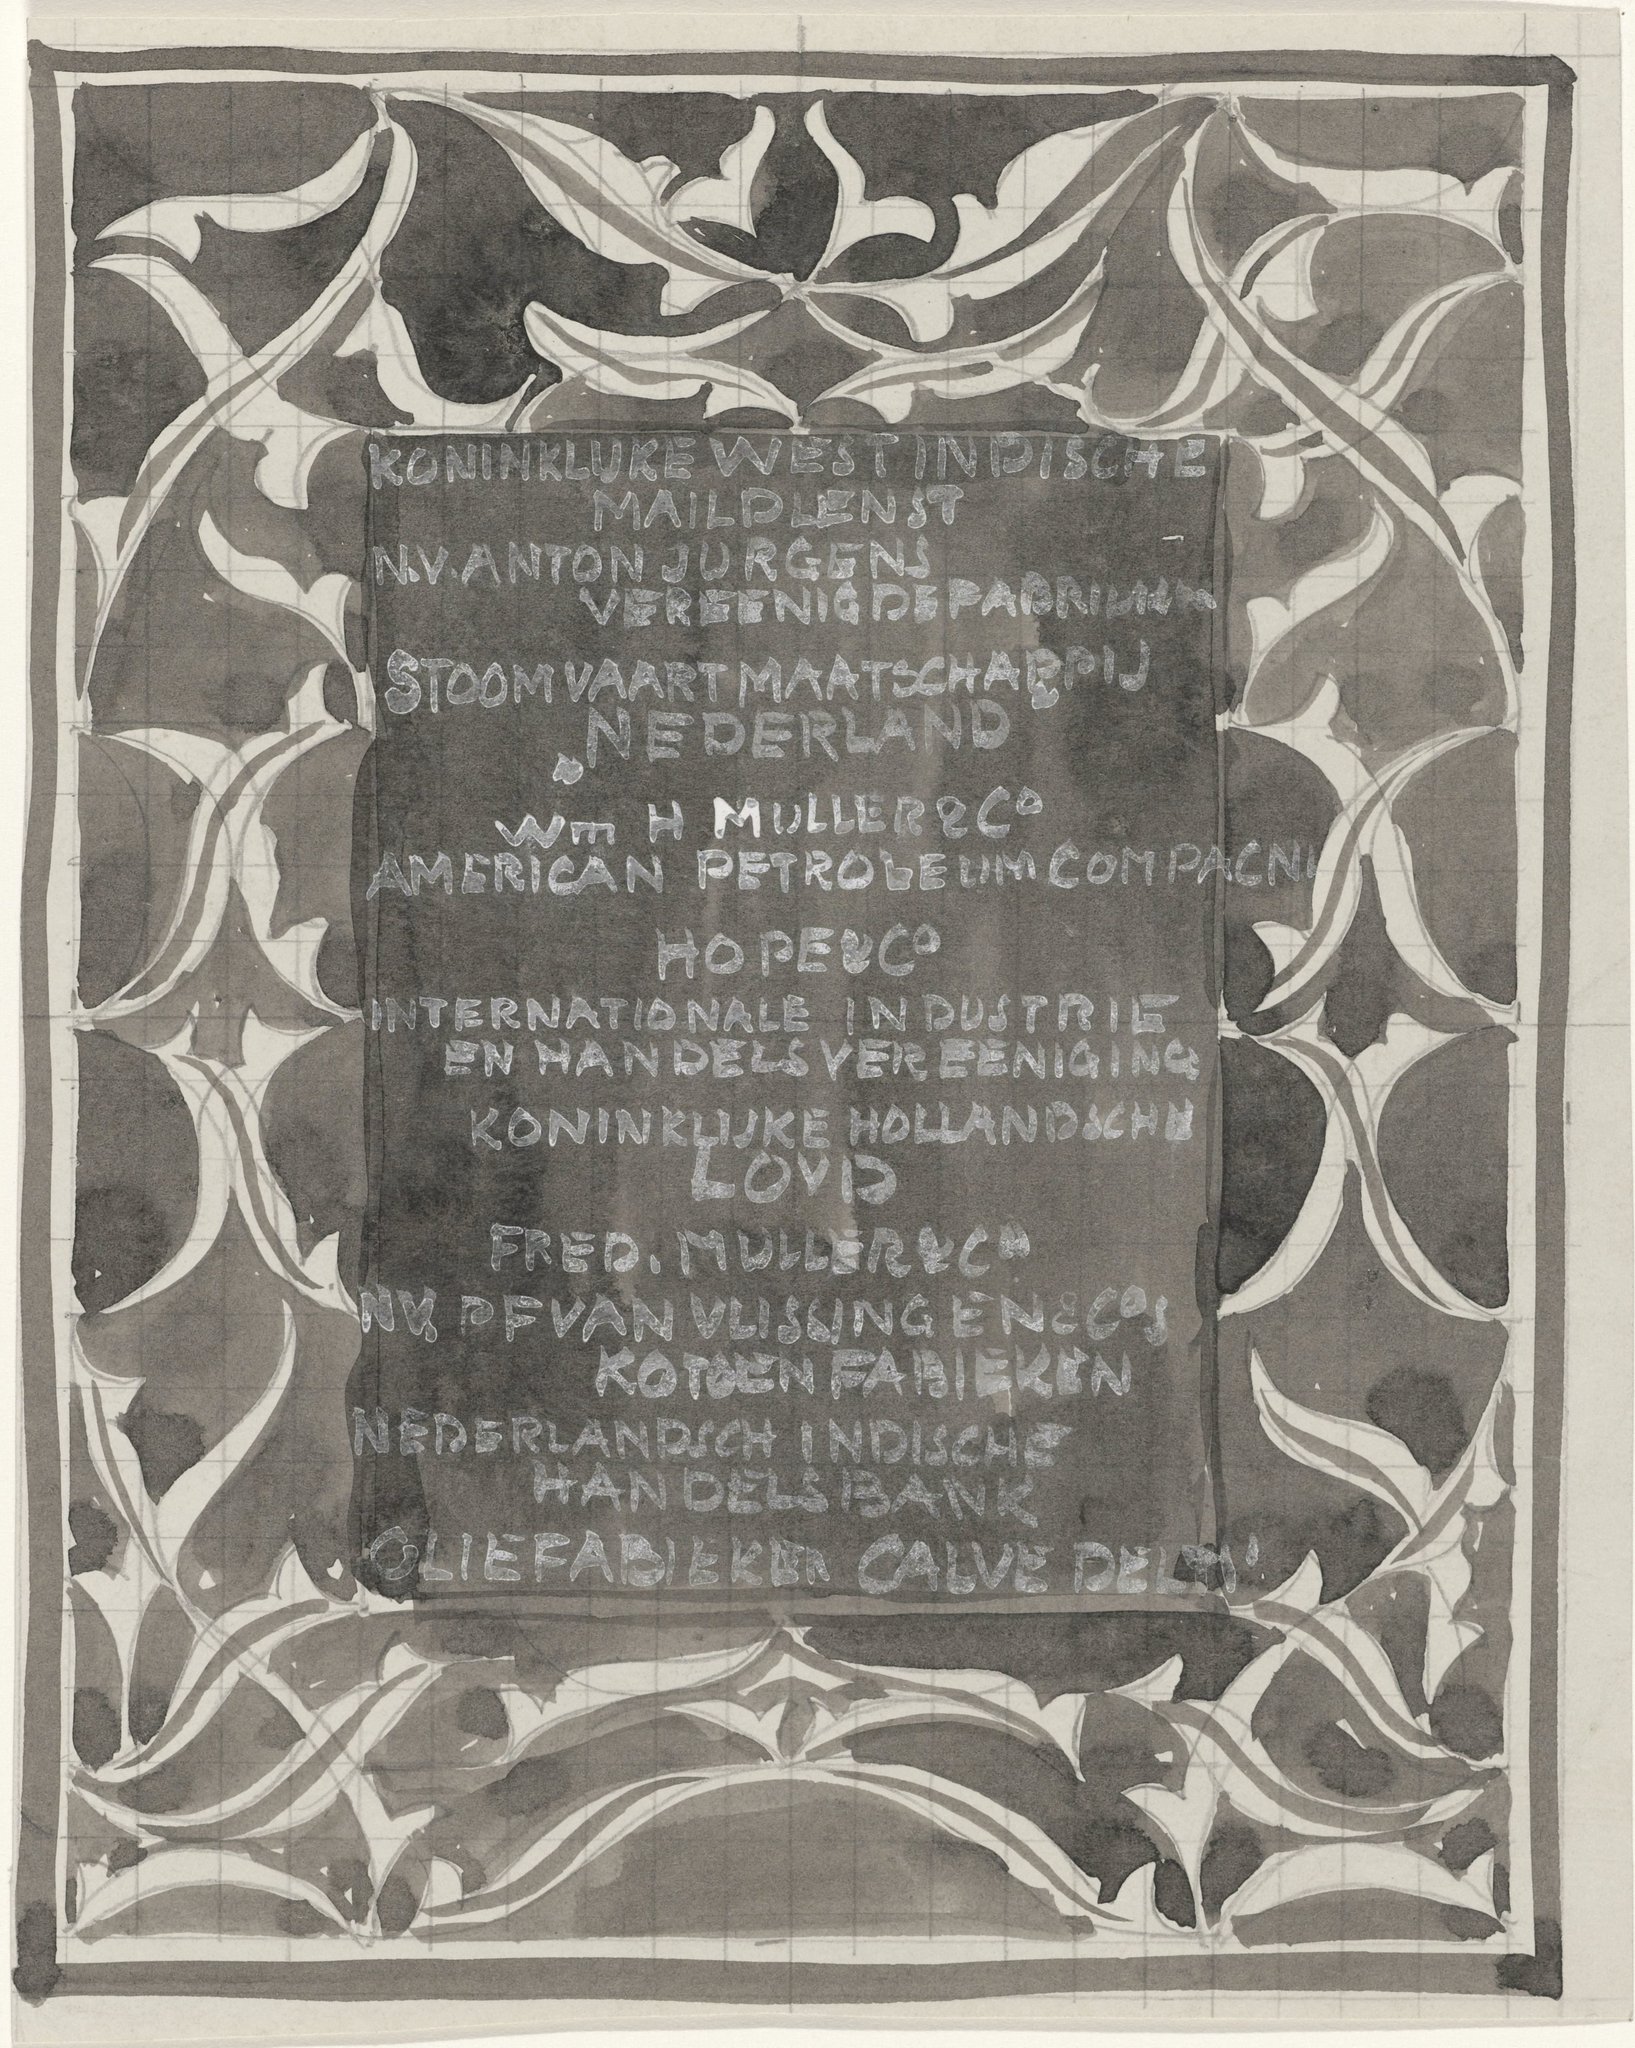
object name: design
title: Ontwerp voor een affiche met namen van bedrijven in ornamentale rand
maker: carel adolph lion cachet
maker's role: draughtsman, print maker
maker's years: 1864-1945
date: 1874-1945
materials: paper, pencil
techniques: brush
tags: poster